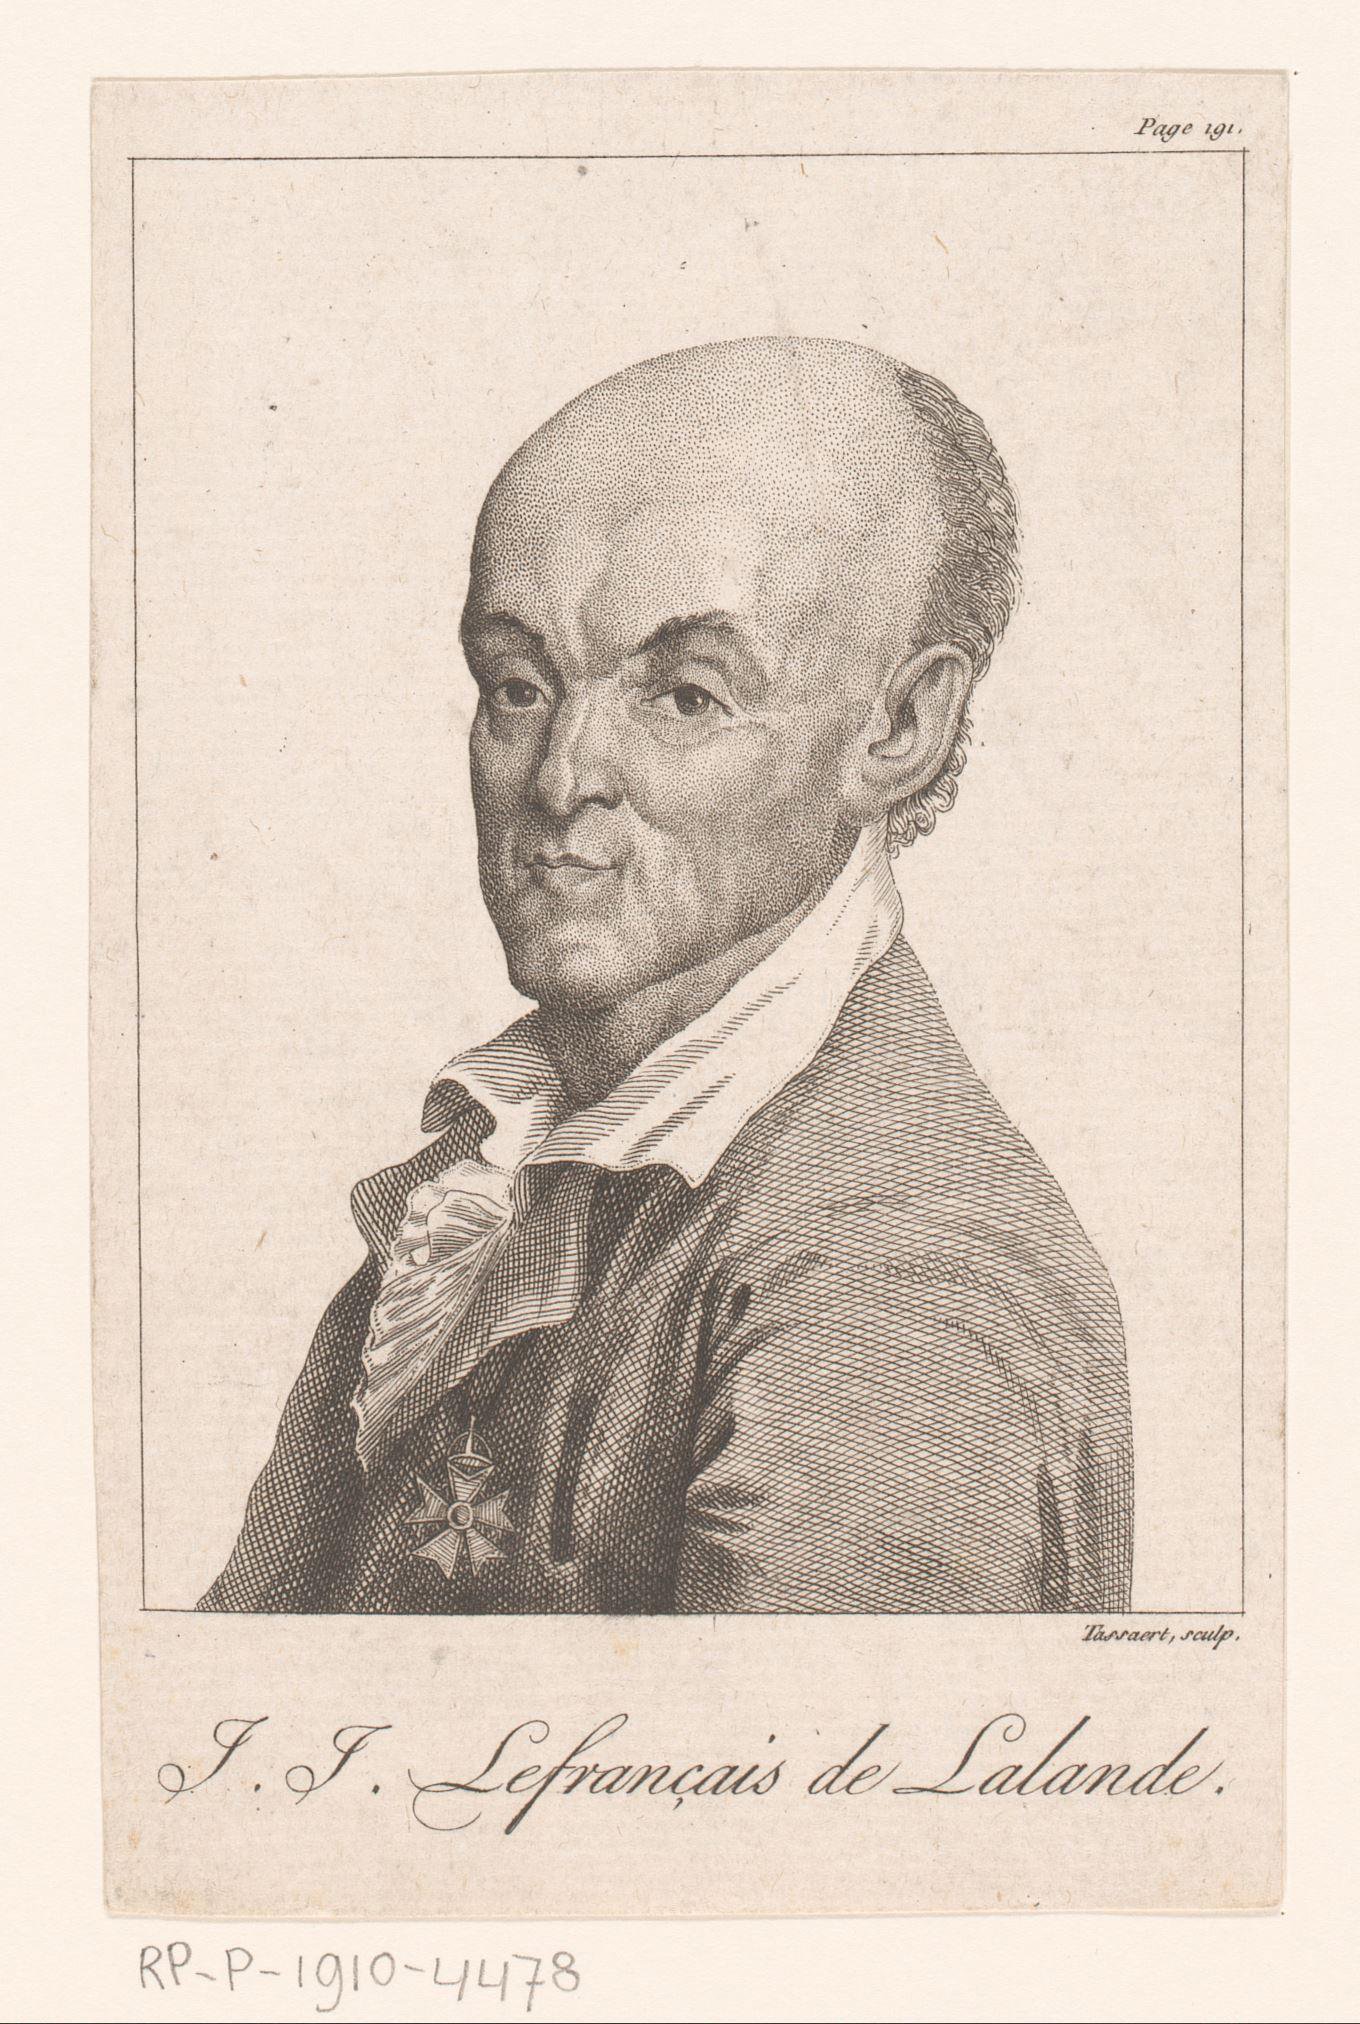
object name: print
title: Portret van Joseph Jérôme Lefrançois de Lalande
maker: paul tassaert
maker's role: print maker, publisher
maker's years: -1855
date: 1775-1855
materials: paper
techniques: engraving, etching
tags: paris, historical persons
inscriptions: collector's mark: Lugt 2228